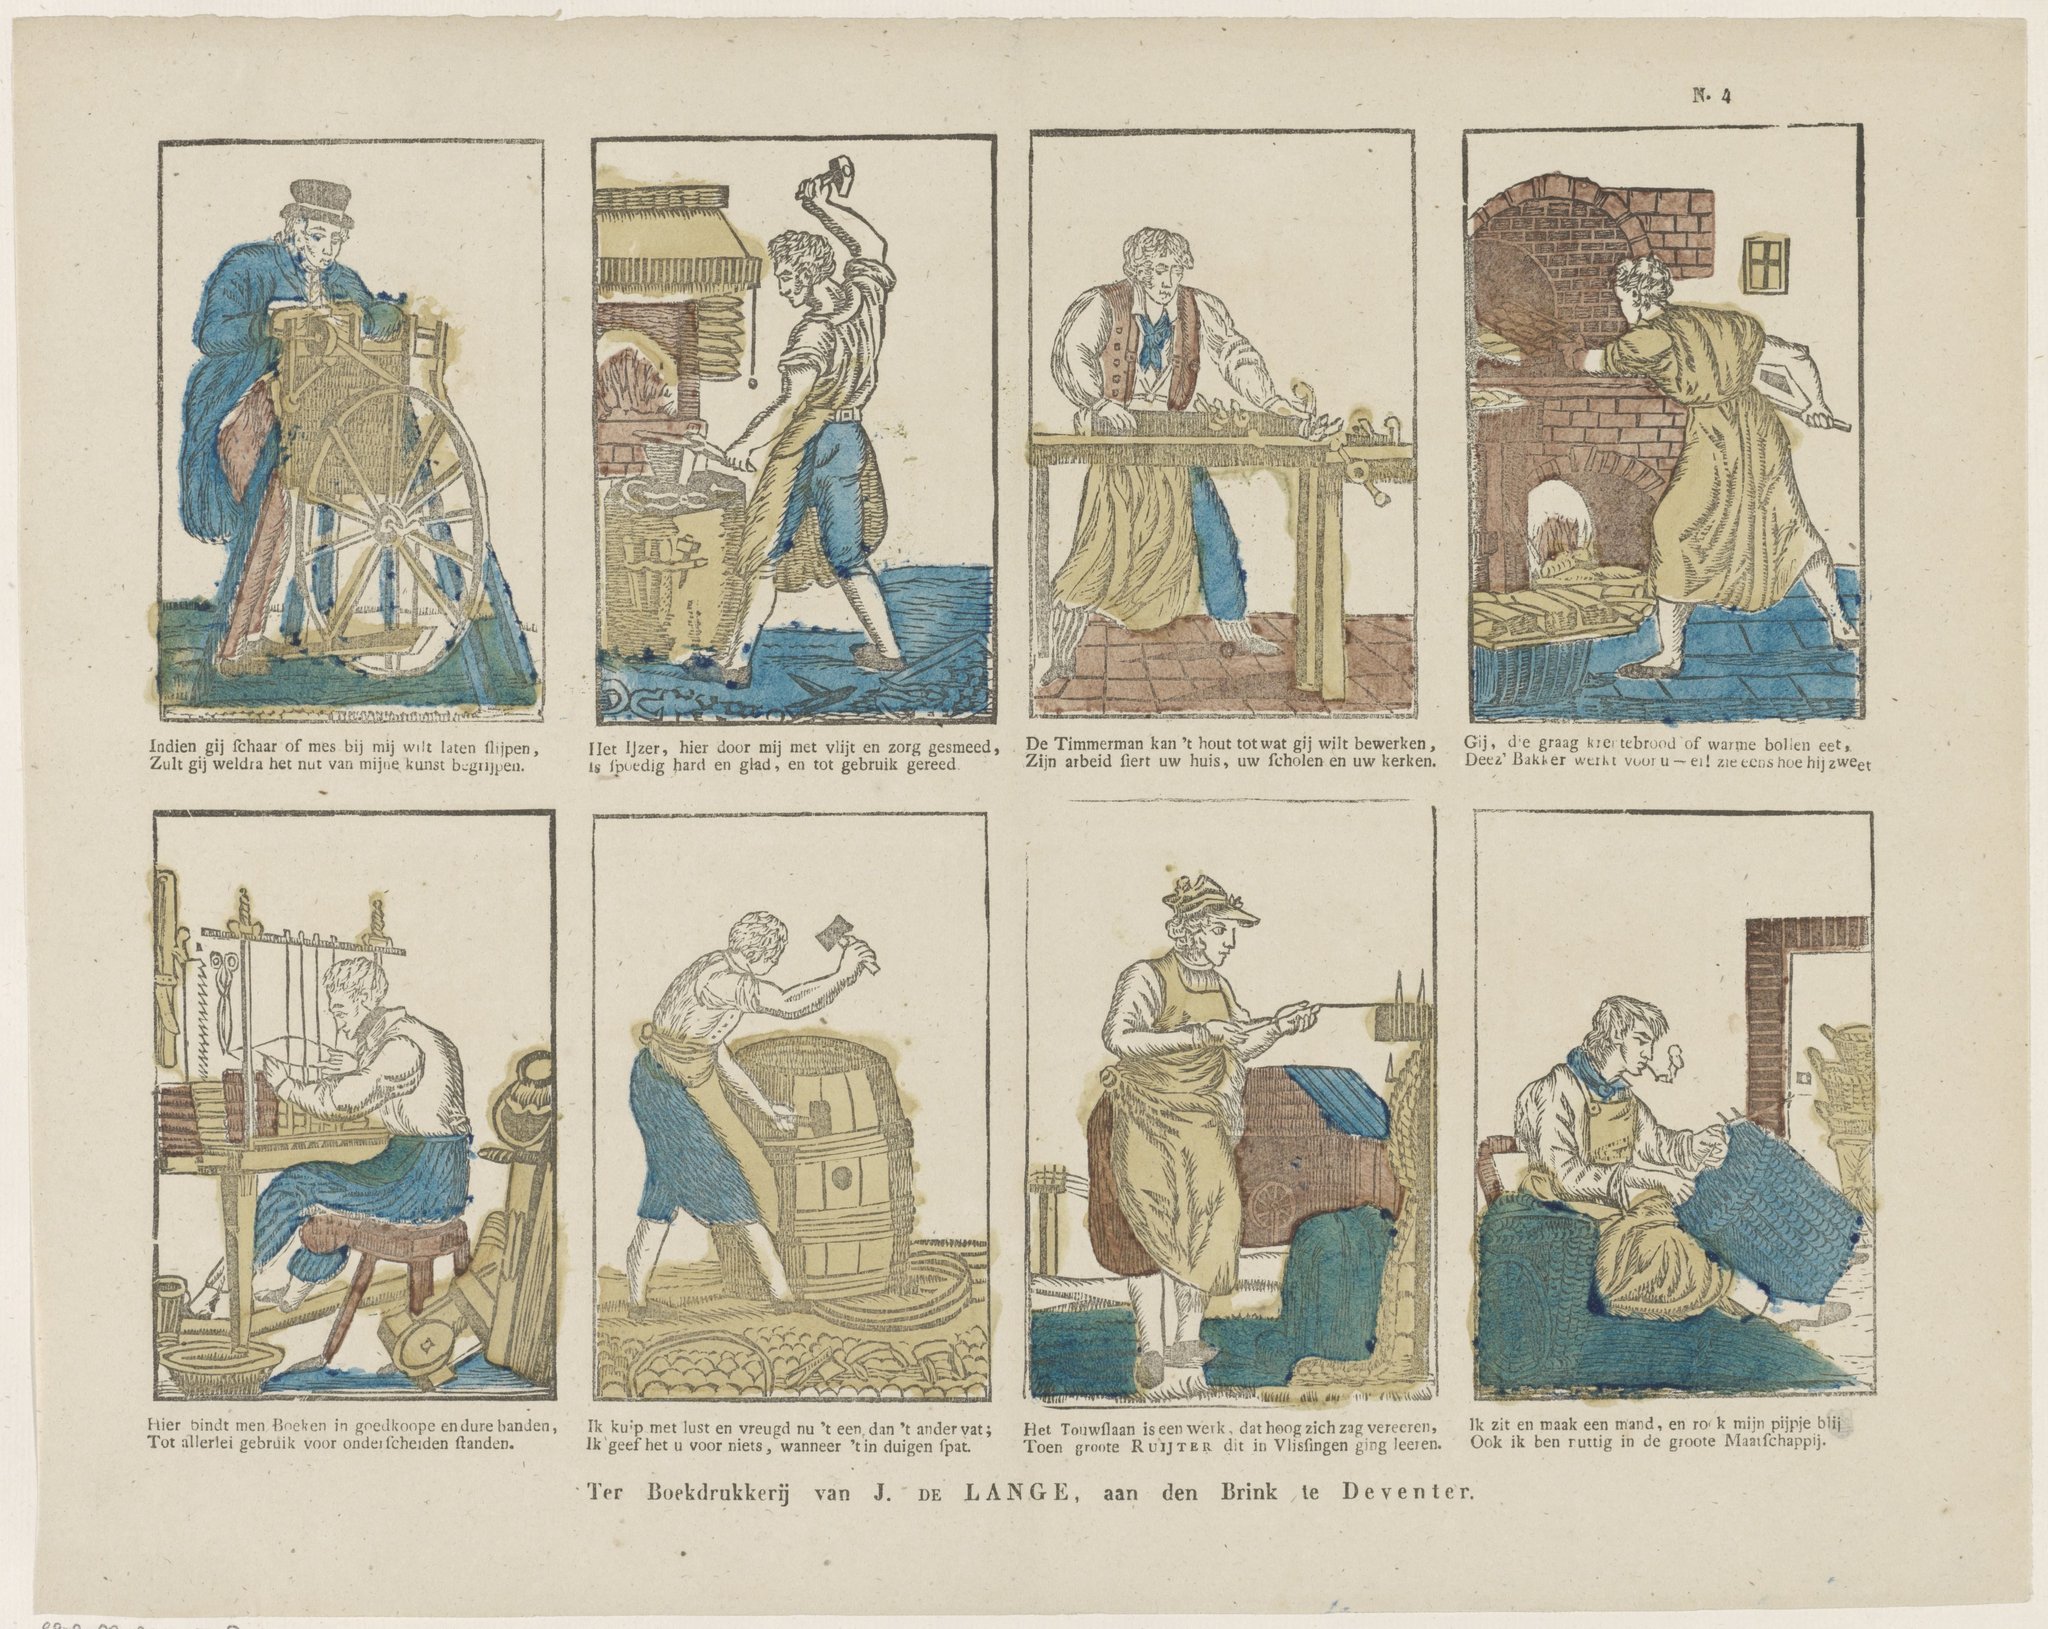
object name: popular print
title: Ambachtslieden en beroepen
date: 1822-1849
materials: paper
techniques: colour, letterpress printing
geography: deventer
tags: carpenter, craft-production, skilled handiwork, working class, labourers, baker, smith, blacksmith, crafts and industries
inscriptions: collector's mark: Lugt 2760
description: Blad met 8 voorstellingen van ambachtslieden en beroepen, zoals messenslijper, smid en timmerman. Onder elke afbeelding een tweeregelig vers. Genummerd rechtsboven: N. 4.